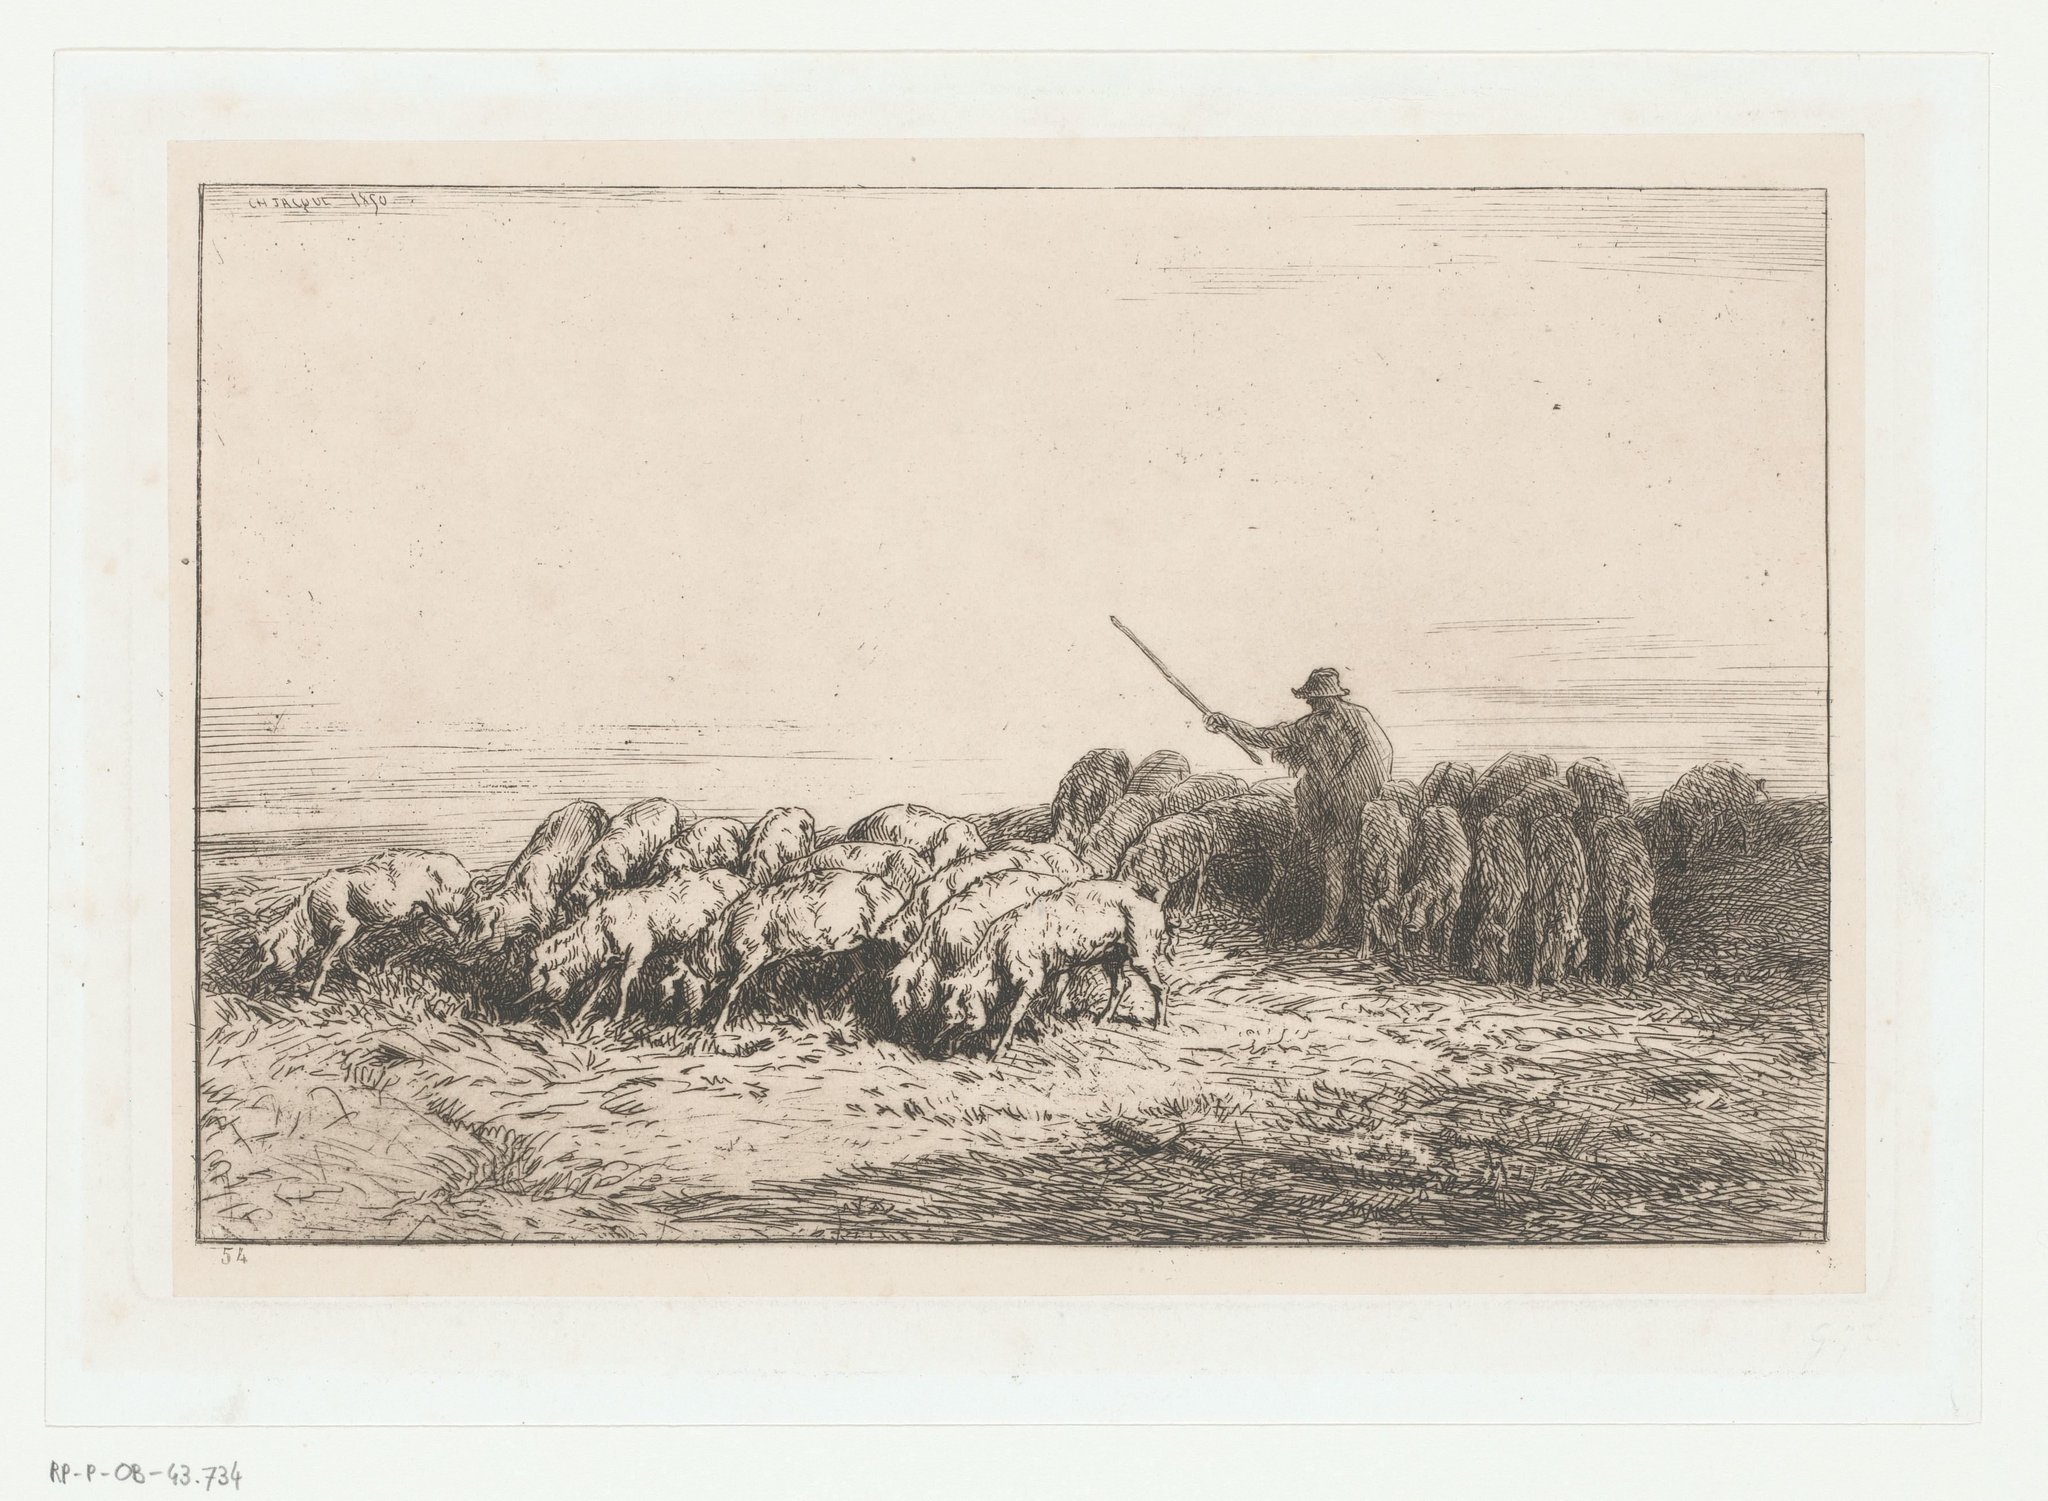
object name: print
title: Varkenshoeder met kudde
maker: charles emile jacque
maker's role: draughtsman, painter, print maker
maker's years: 1813-1894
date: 1850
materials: paper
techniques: etching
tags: pig, occupations ~ cattle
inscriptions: collector's mark: Lugt 2228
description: Prent ook gebruikt voor een twintigdelige serie met verschillende onderwerpen door Jacque, getiteld '20 sujets composés et gravés à l'eau-forte par Ch. Jacque'.